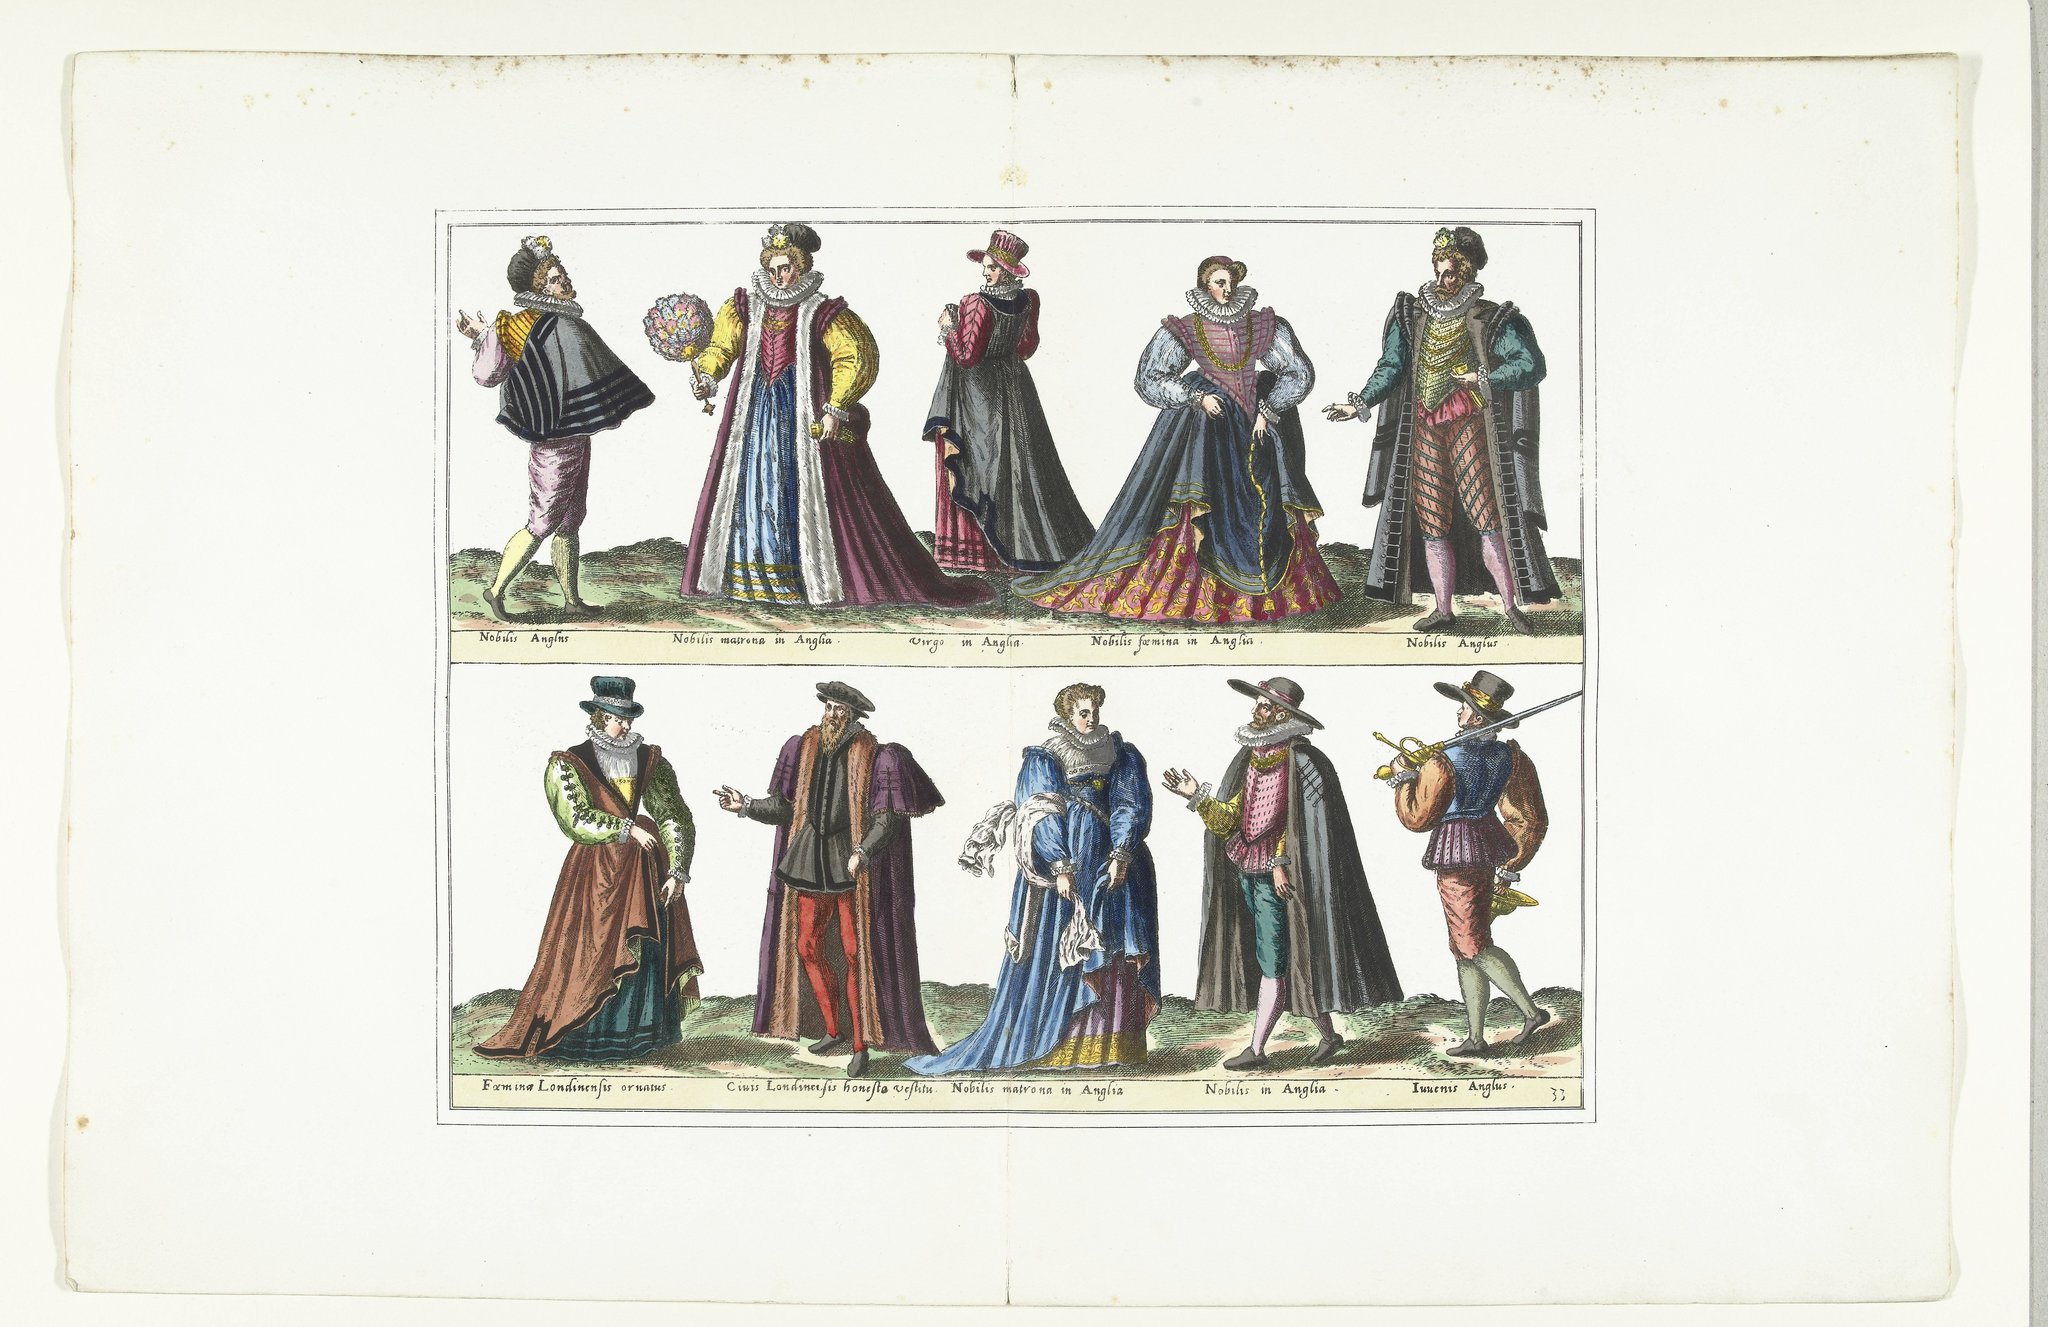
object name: costume print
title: Costumes Anglais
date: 1872-1875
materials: paper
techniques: hand coloring, printing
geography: brussels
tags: clothes, costume (+ men's clothes), england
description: Onderdeel van Costumes civils et militaires du XVIe siècle par A. de Bruyn, een selectie van prenten uit de Trachtenbuch van Abraham de Bruyn uit 1581 (Hollstein 248-306), in facsimile. Losbladig uitgegeven met titelbladen, verklaring en lijst van de platen door G.A. van Trigt te Brussel in 1875 met teksten van Auguste Schoy. In de Rijksmuseum Research Library met signatuur 34 C 43.